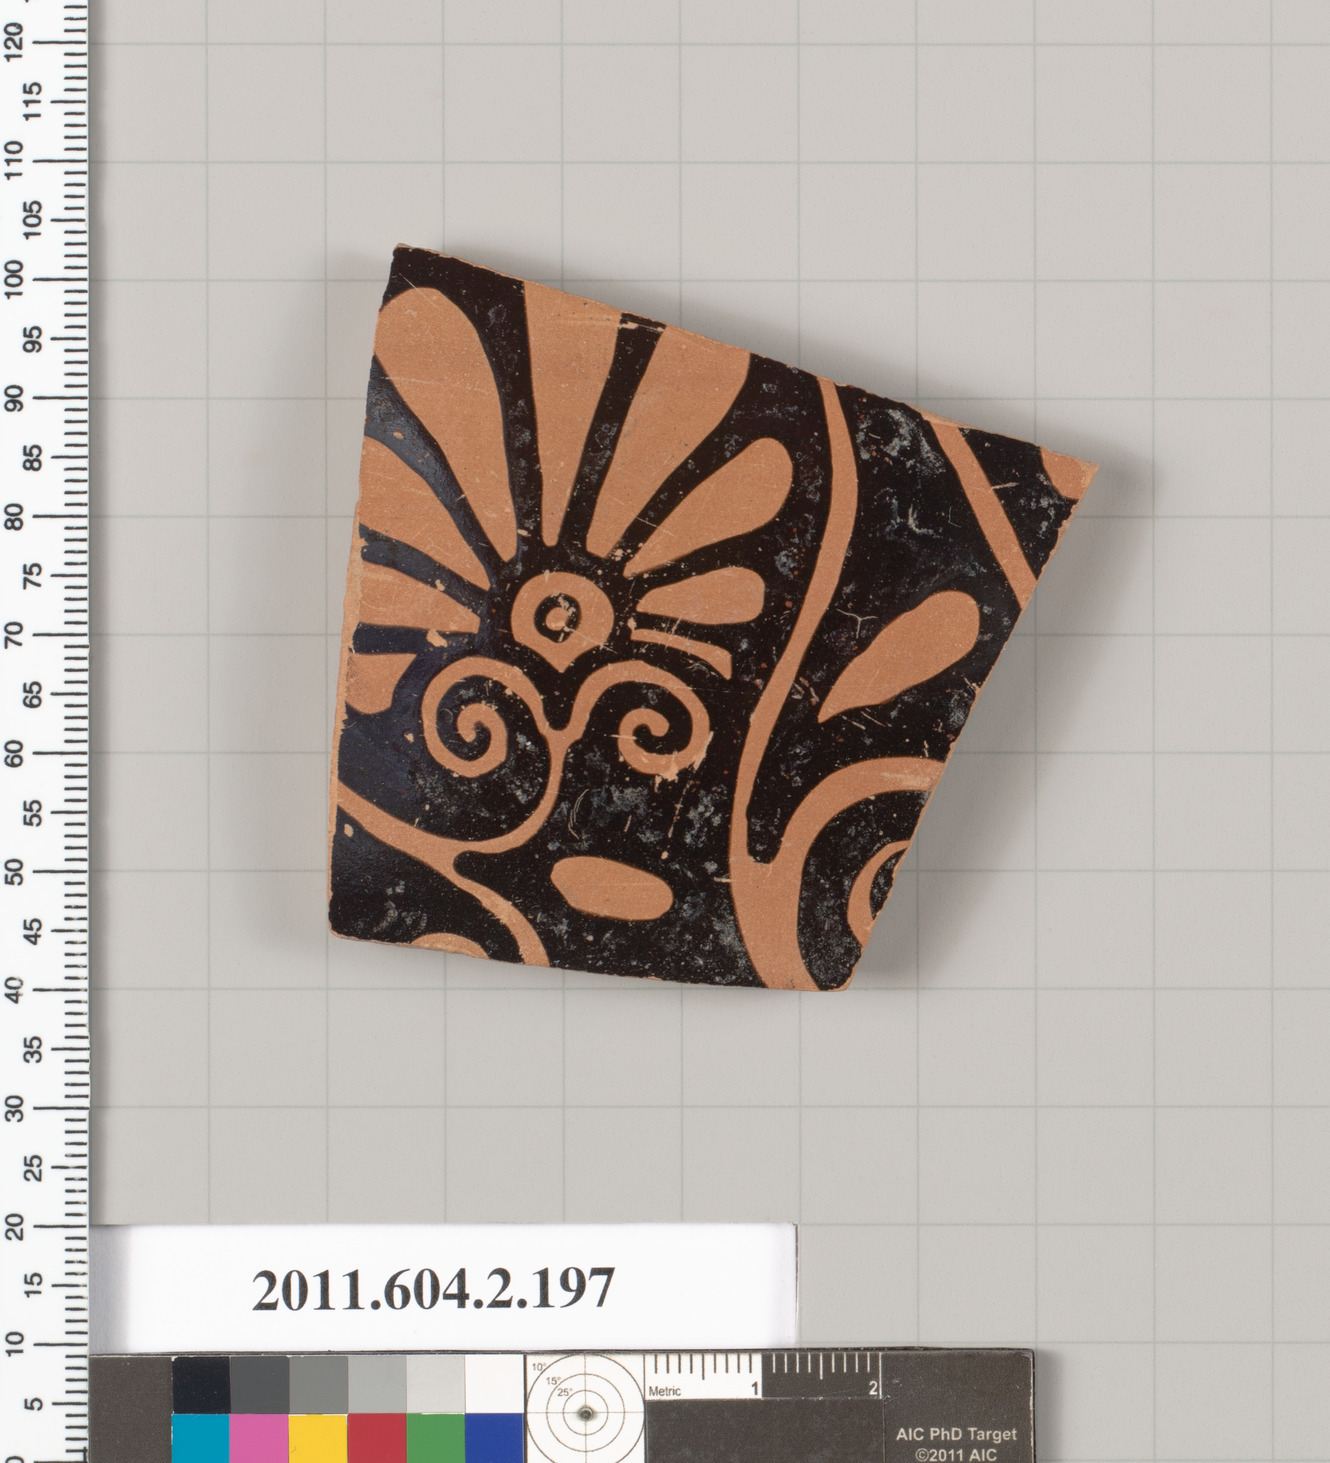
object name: stamnos fragment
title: Terracotta fragment of a stamnos (jar)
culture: greek, attic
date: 475-451 BCE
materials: terracotta